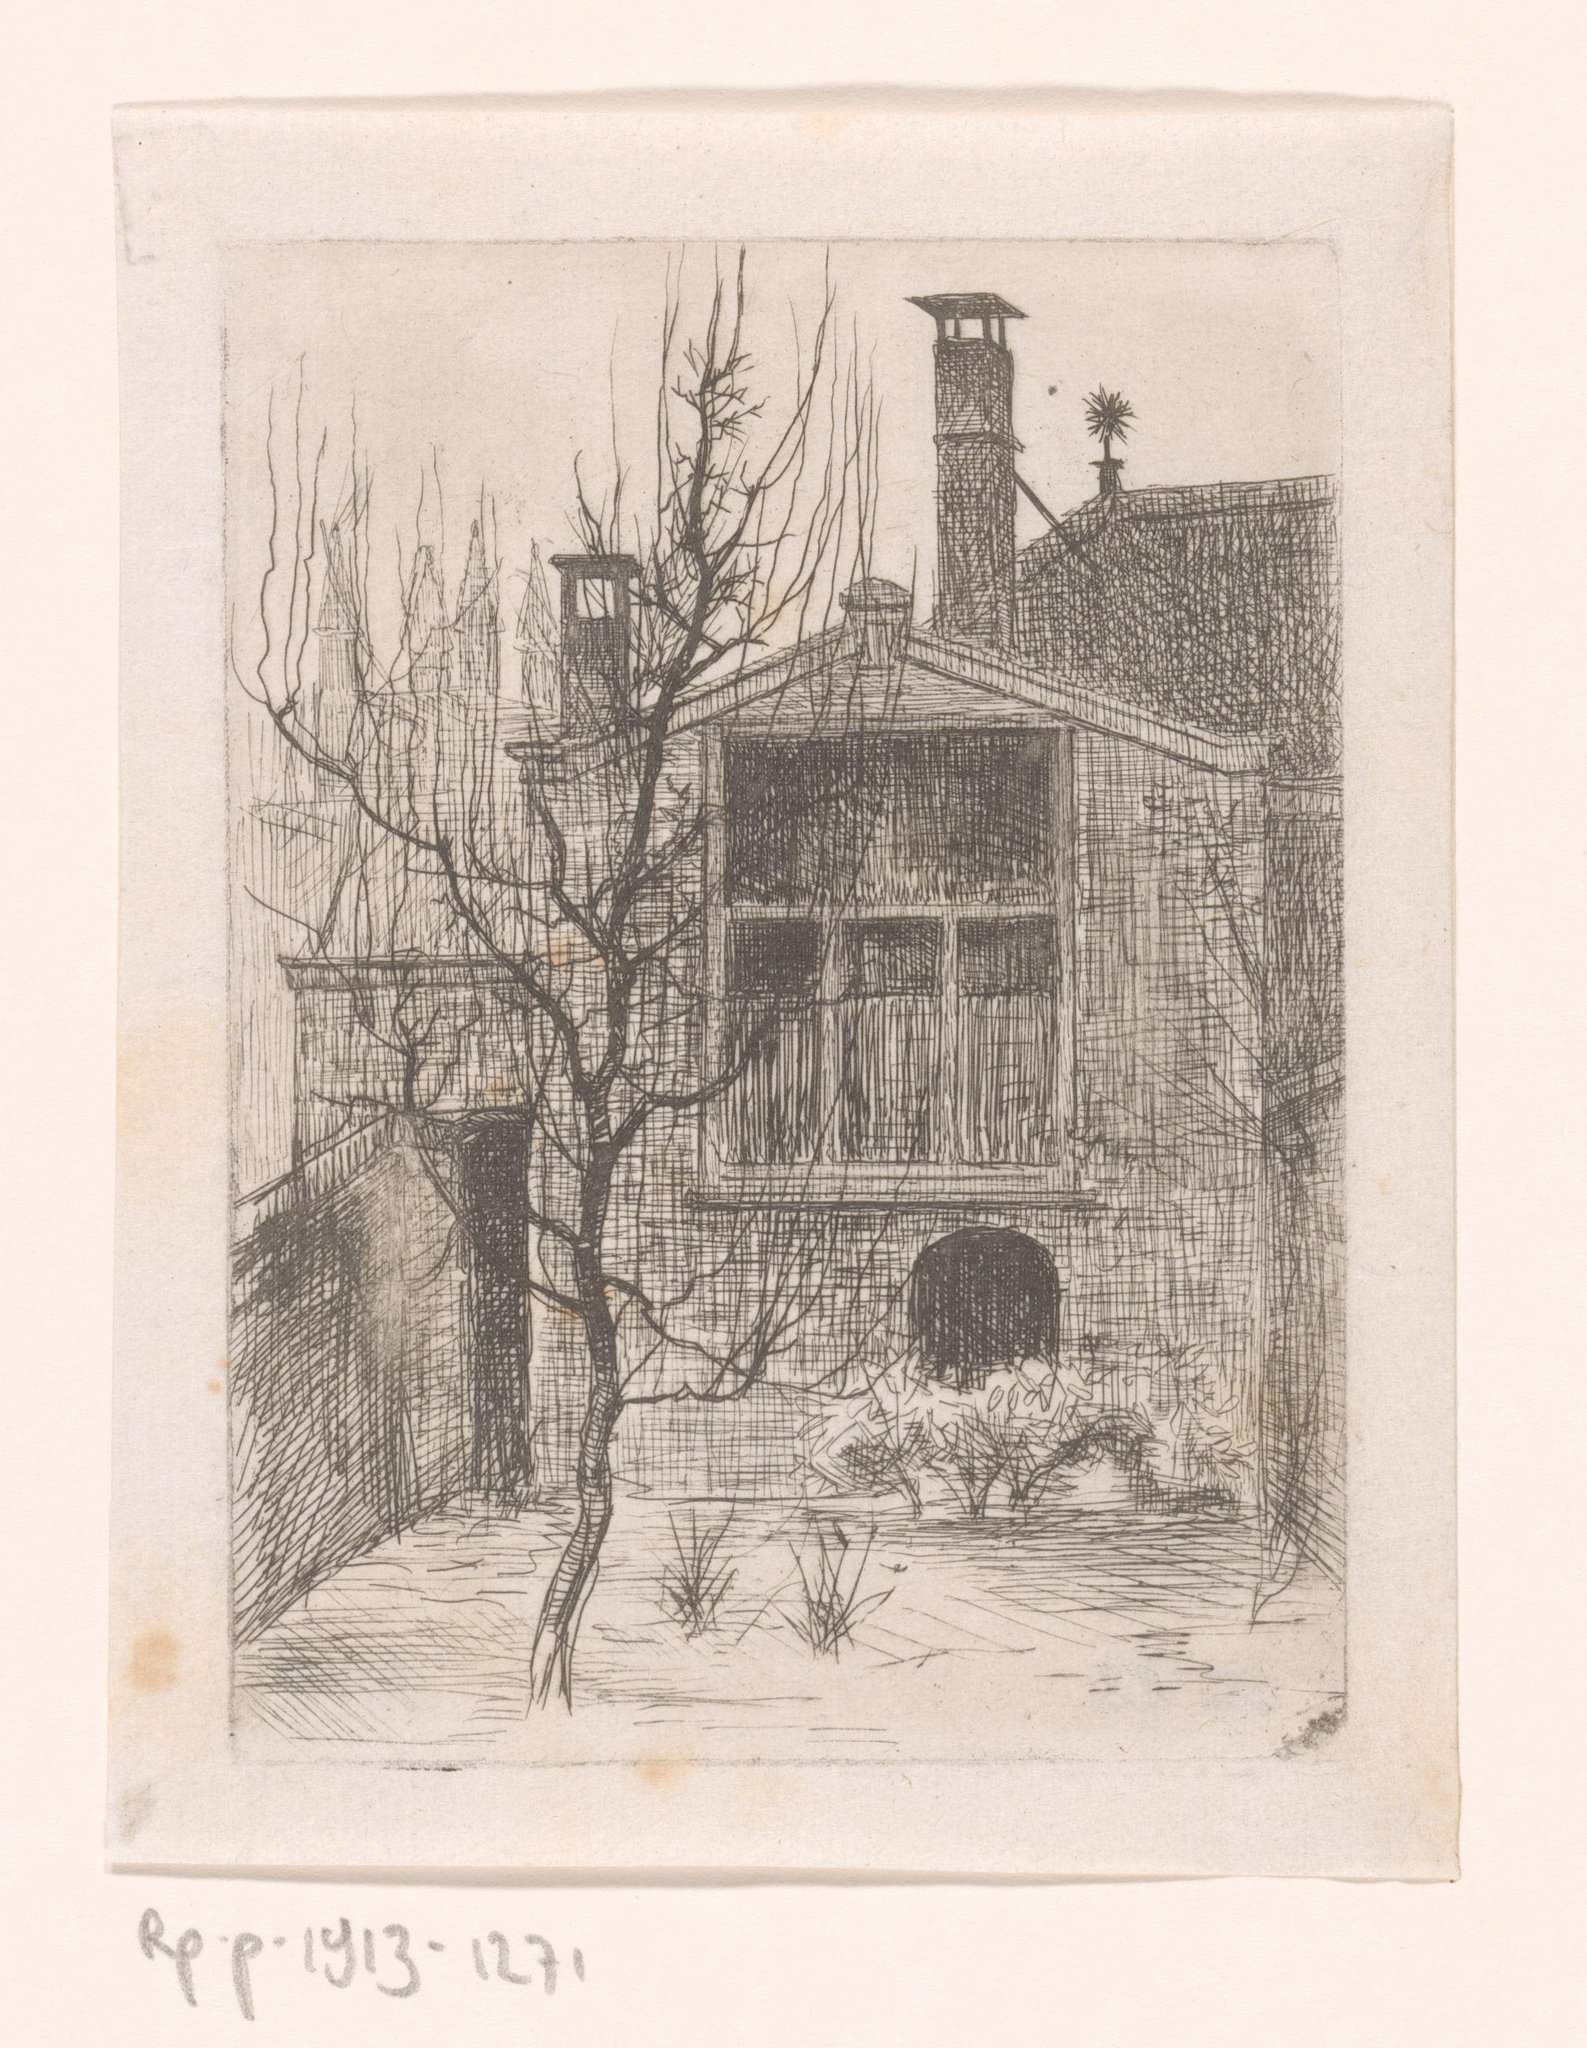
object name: print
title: Atelier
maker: philip zilcken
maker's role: draughtsman, painter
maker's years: 1857-1930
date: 1867-1890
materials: paper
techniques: etching, intaglio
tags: workshop, studio ~ painter, the hague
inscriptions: collector's mark: Lugt 2233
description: Dit is het atelier van de kunstenaar aan de Javastraat 7, te Den Haag. Op de achtergrond zijn de torens van de Willemskerk te zien.